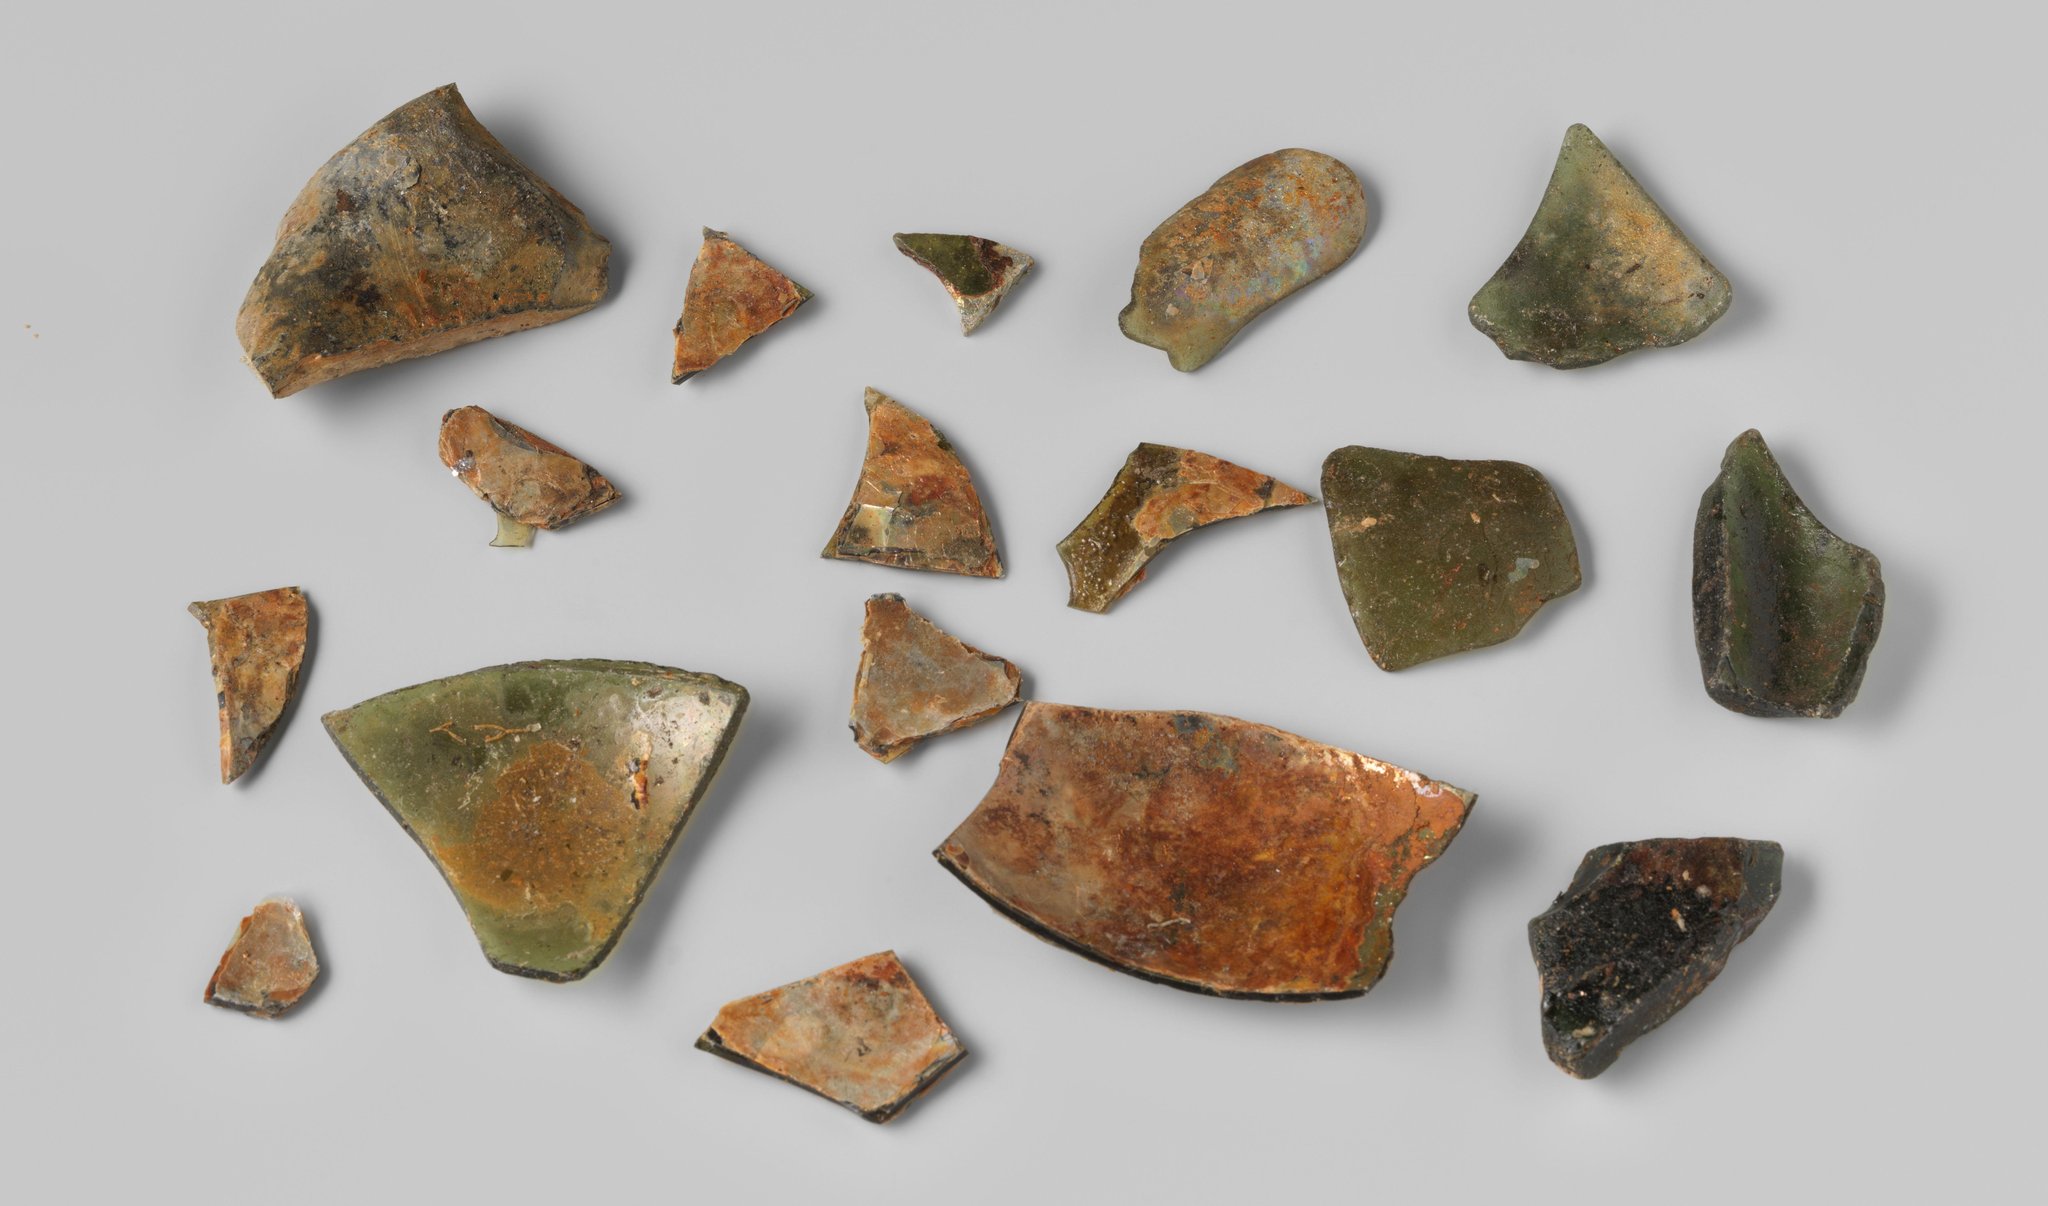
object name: wine bottle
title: Scherven van wijnflessen uit het wrak van de Oostindiëvaarder Hollandia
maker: Anonymous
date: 1700-1743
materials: glass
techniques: green glass